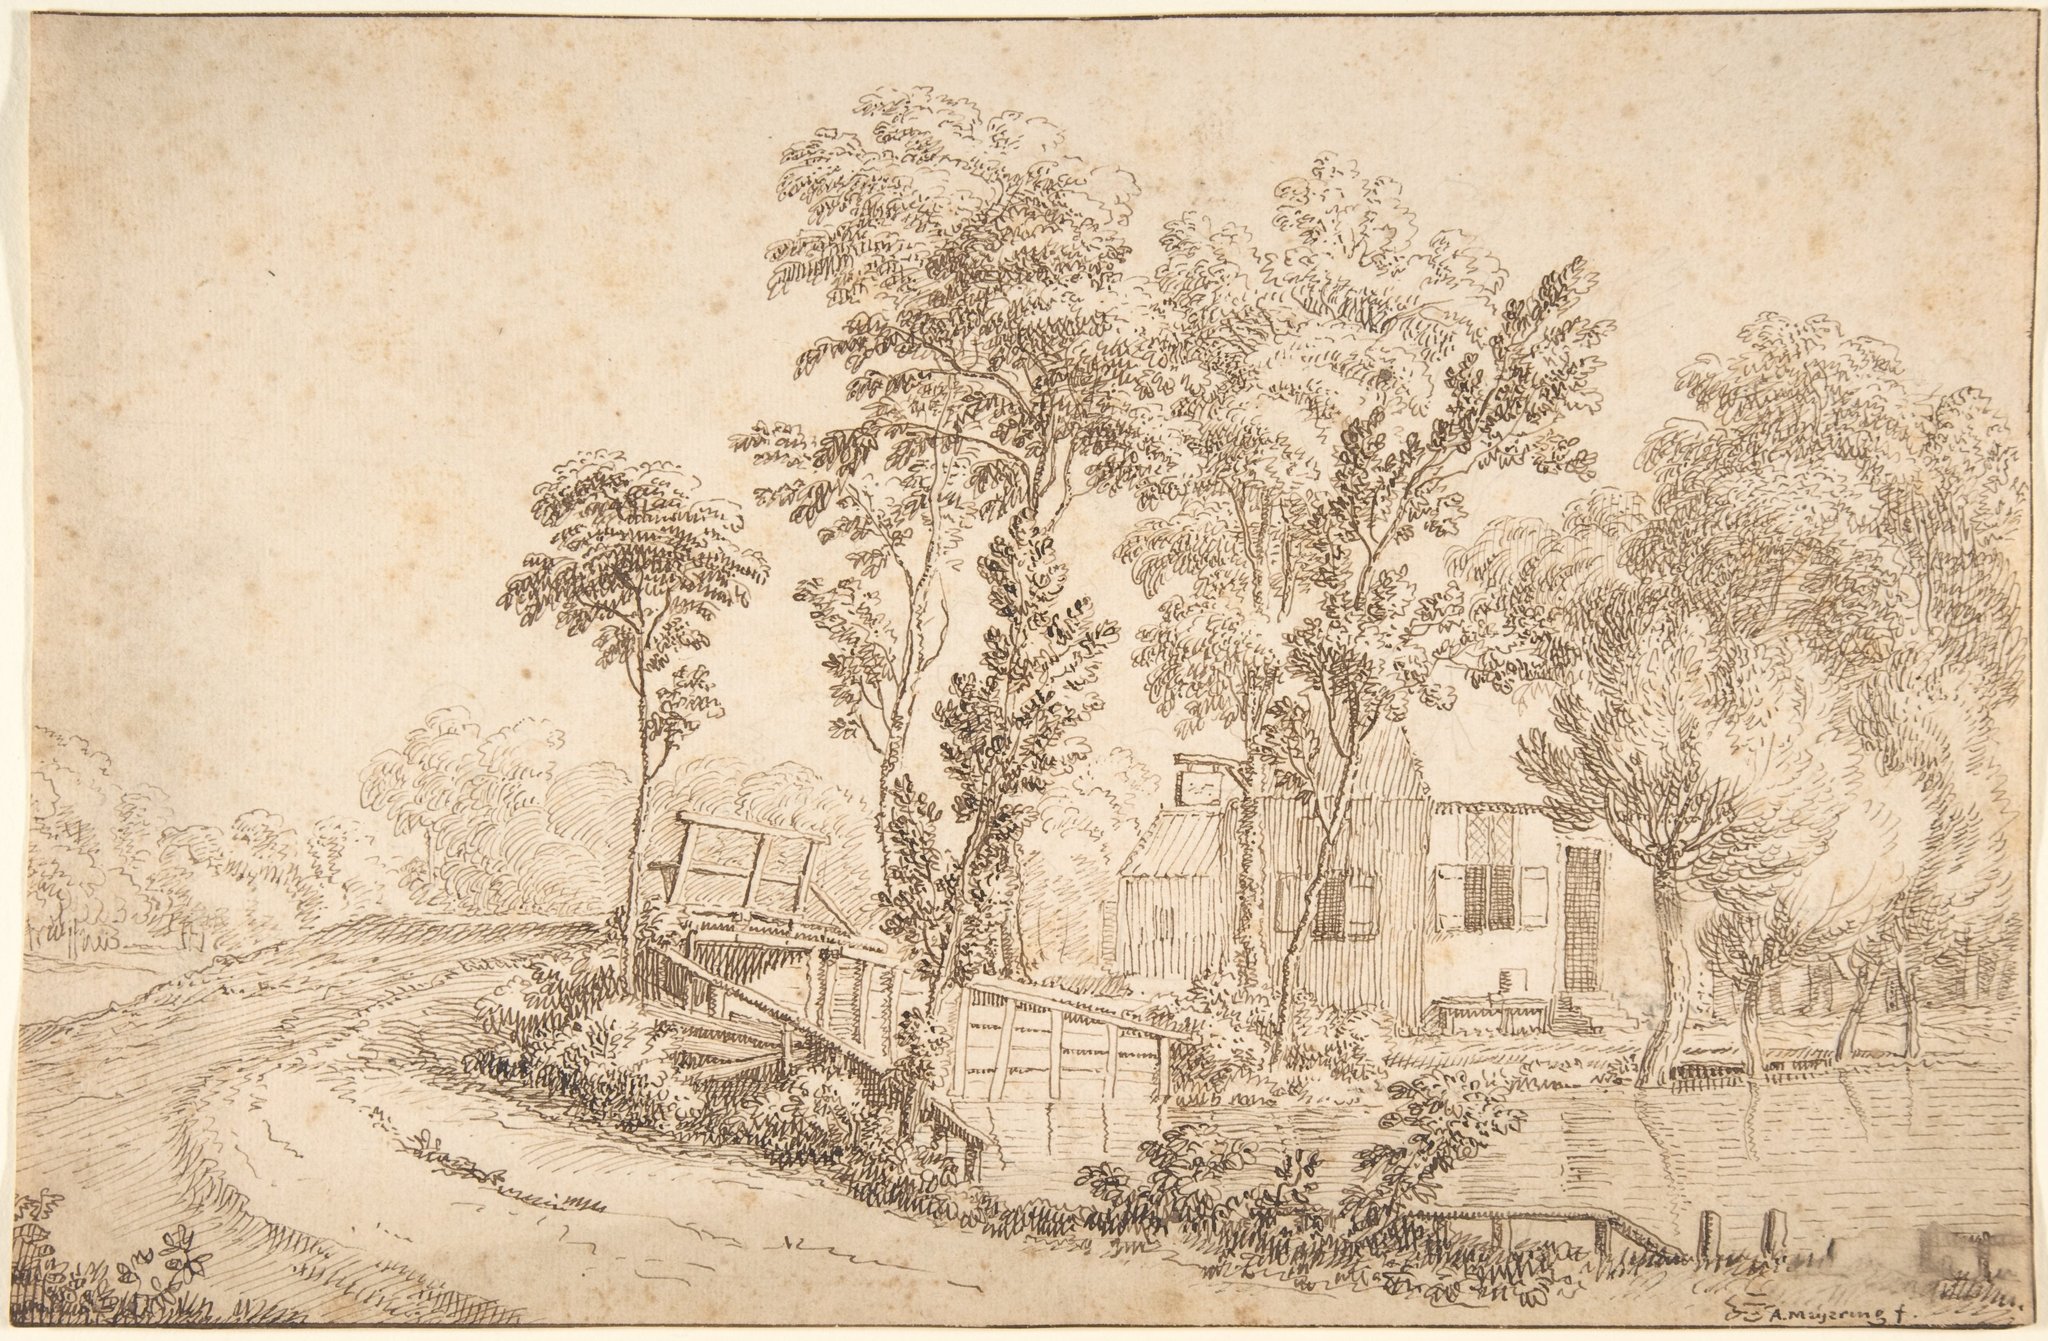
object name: drawing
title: Landscape with a House near a Bridge over a River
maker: albert meyeringh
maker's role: artist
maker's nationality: dutch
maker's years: 1645-1714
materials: ink, paper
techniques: pen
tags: houses,bridges,rivers,landscapes,trees